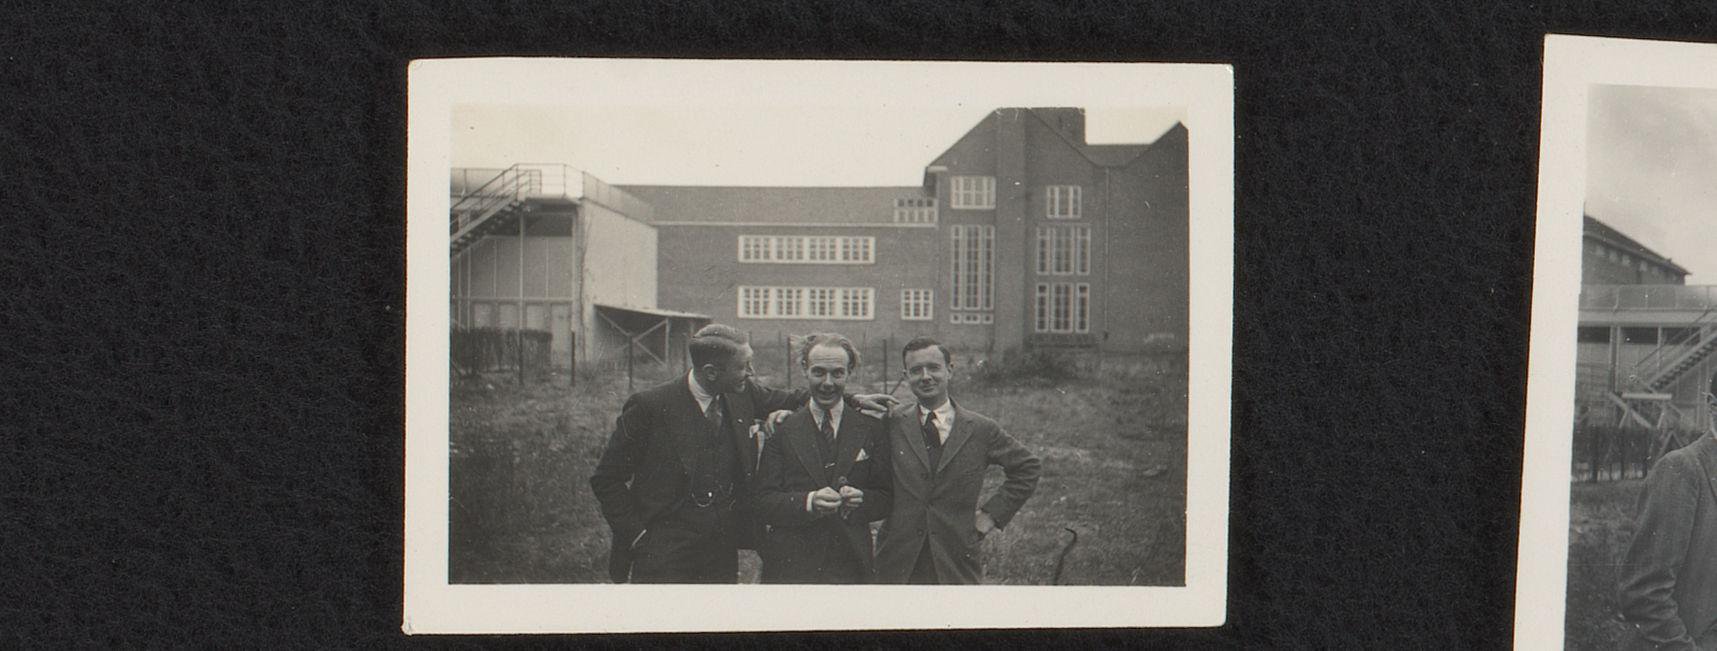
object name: photograph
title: Koenen, Fennema en Van den Berg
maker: Anonymous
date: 1930-1950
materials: photographic support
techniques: gelatin silver print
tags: historical persons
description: Koenen, Fennema en Van den Berg staande voor een gebouw. In envelop met losse foto's behorend bij het fotoalbum over de bewoners van het huis aan de Reguliersgracht te Amsterdam in de periode 1924-1932.